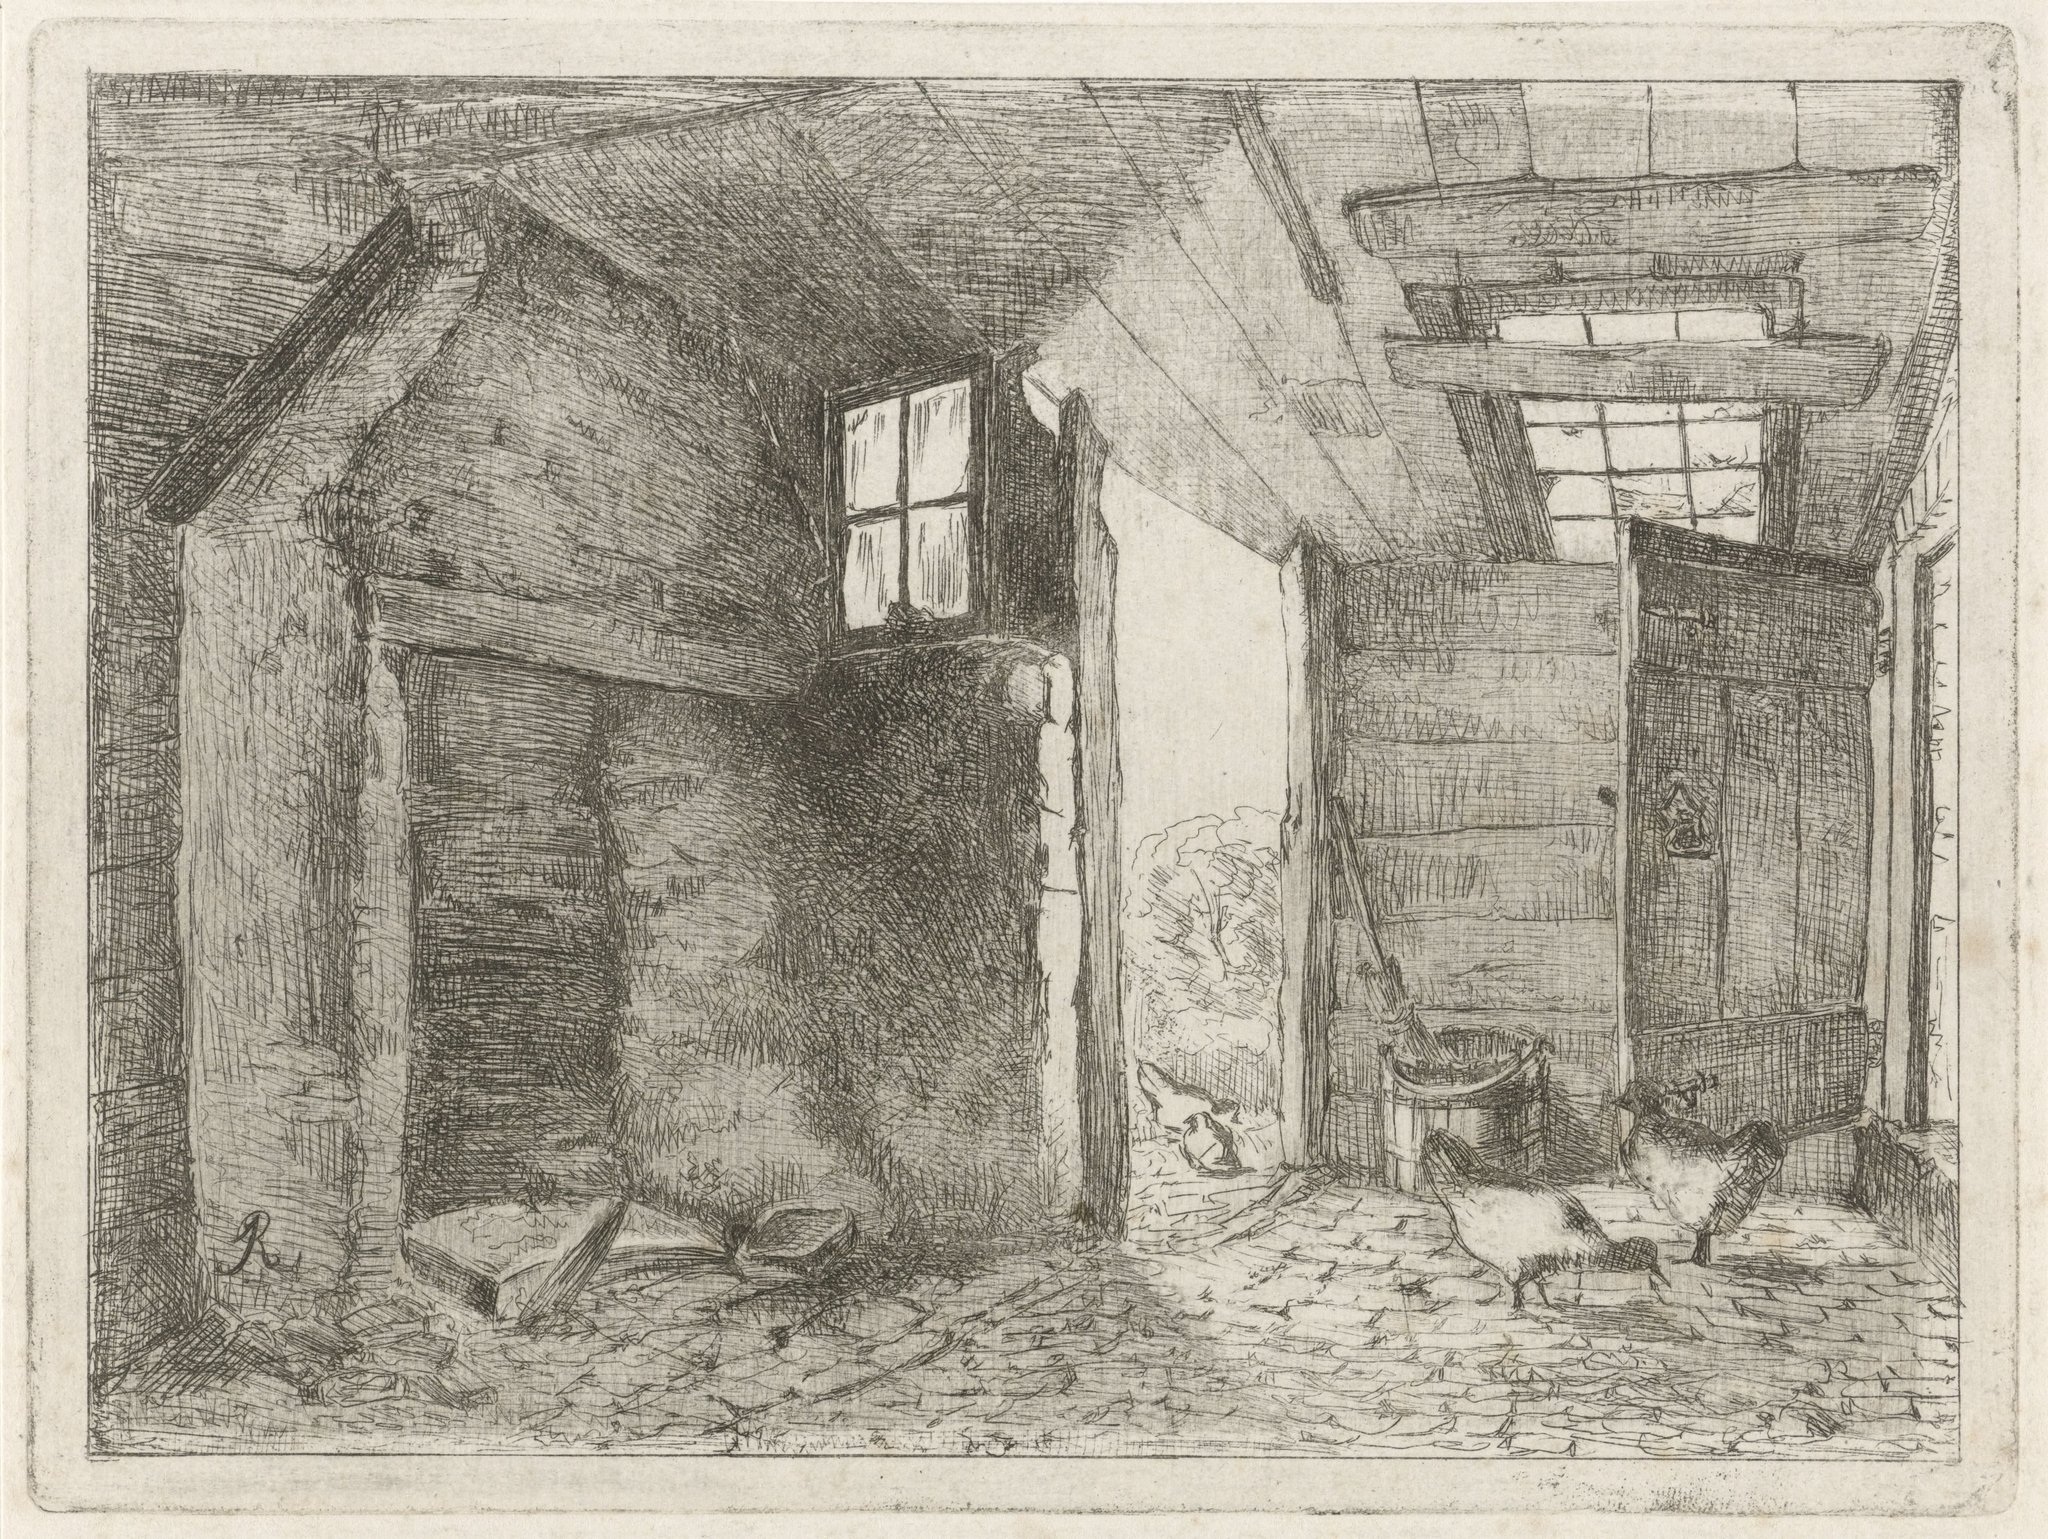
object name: print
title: Schuur met kippen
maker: johannes everhardus rijnboutt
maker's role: print maker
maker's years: 1839-1900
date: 1849-1882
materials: paper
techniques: etching, intaglio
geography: netherlands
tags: fowl (cock, hen, chicken, etc.), shed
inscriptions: collector's mark: Lugt 2228